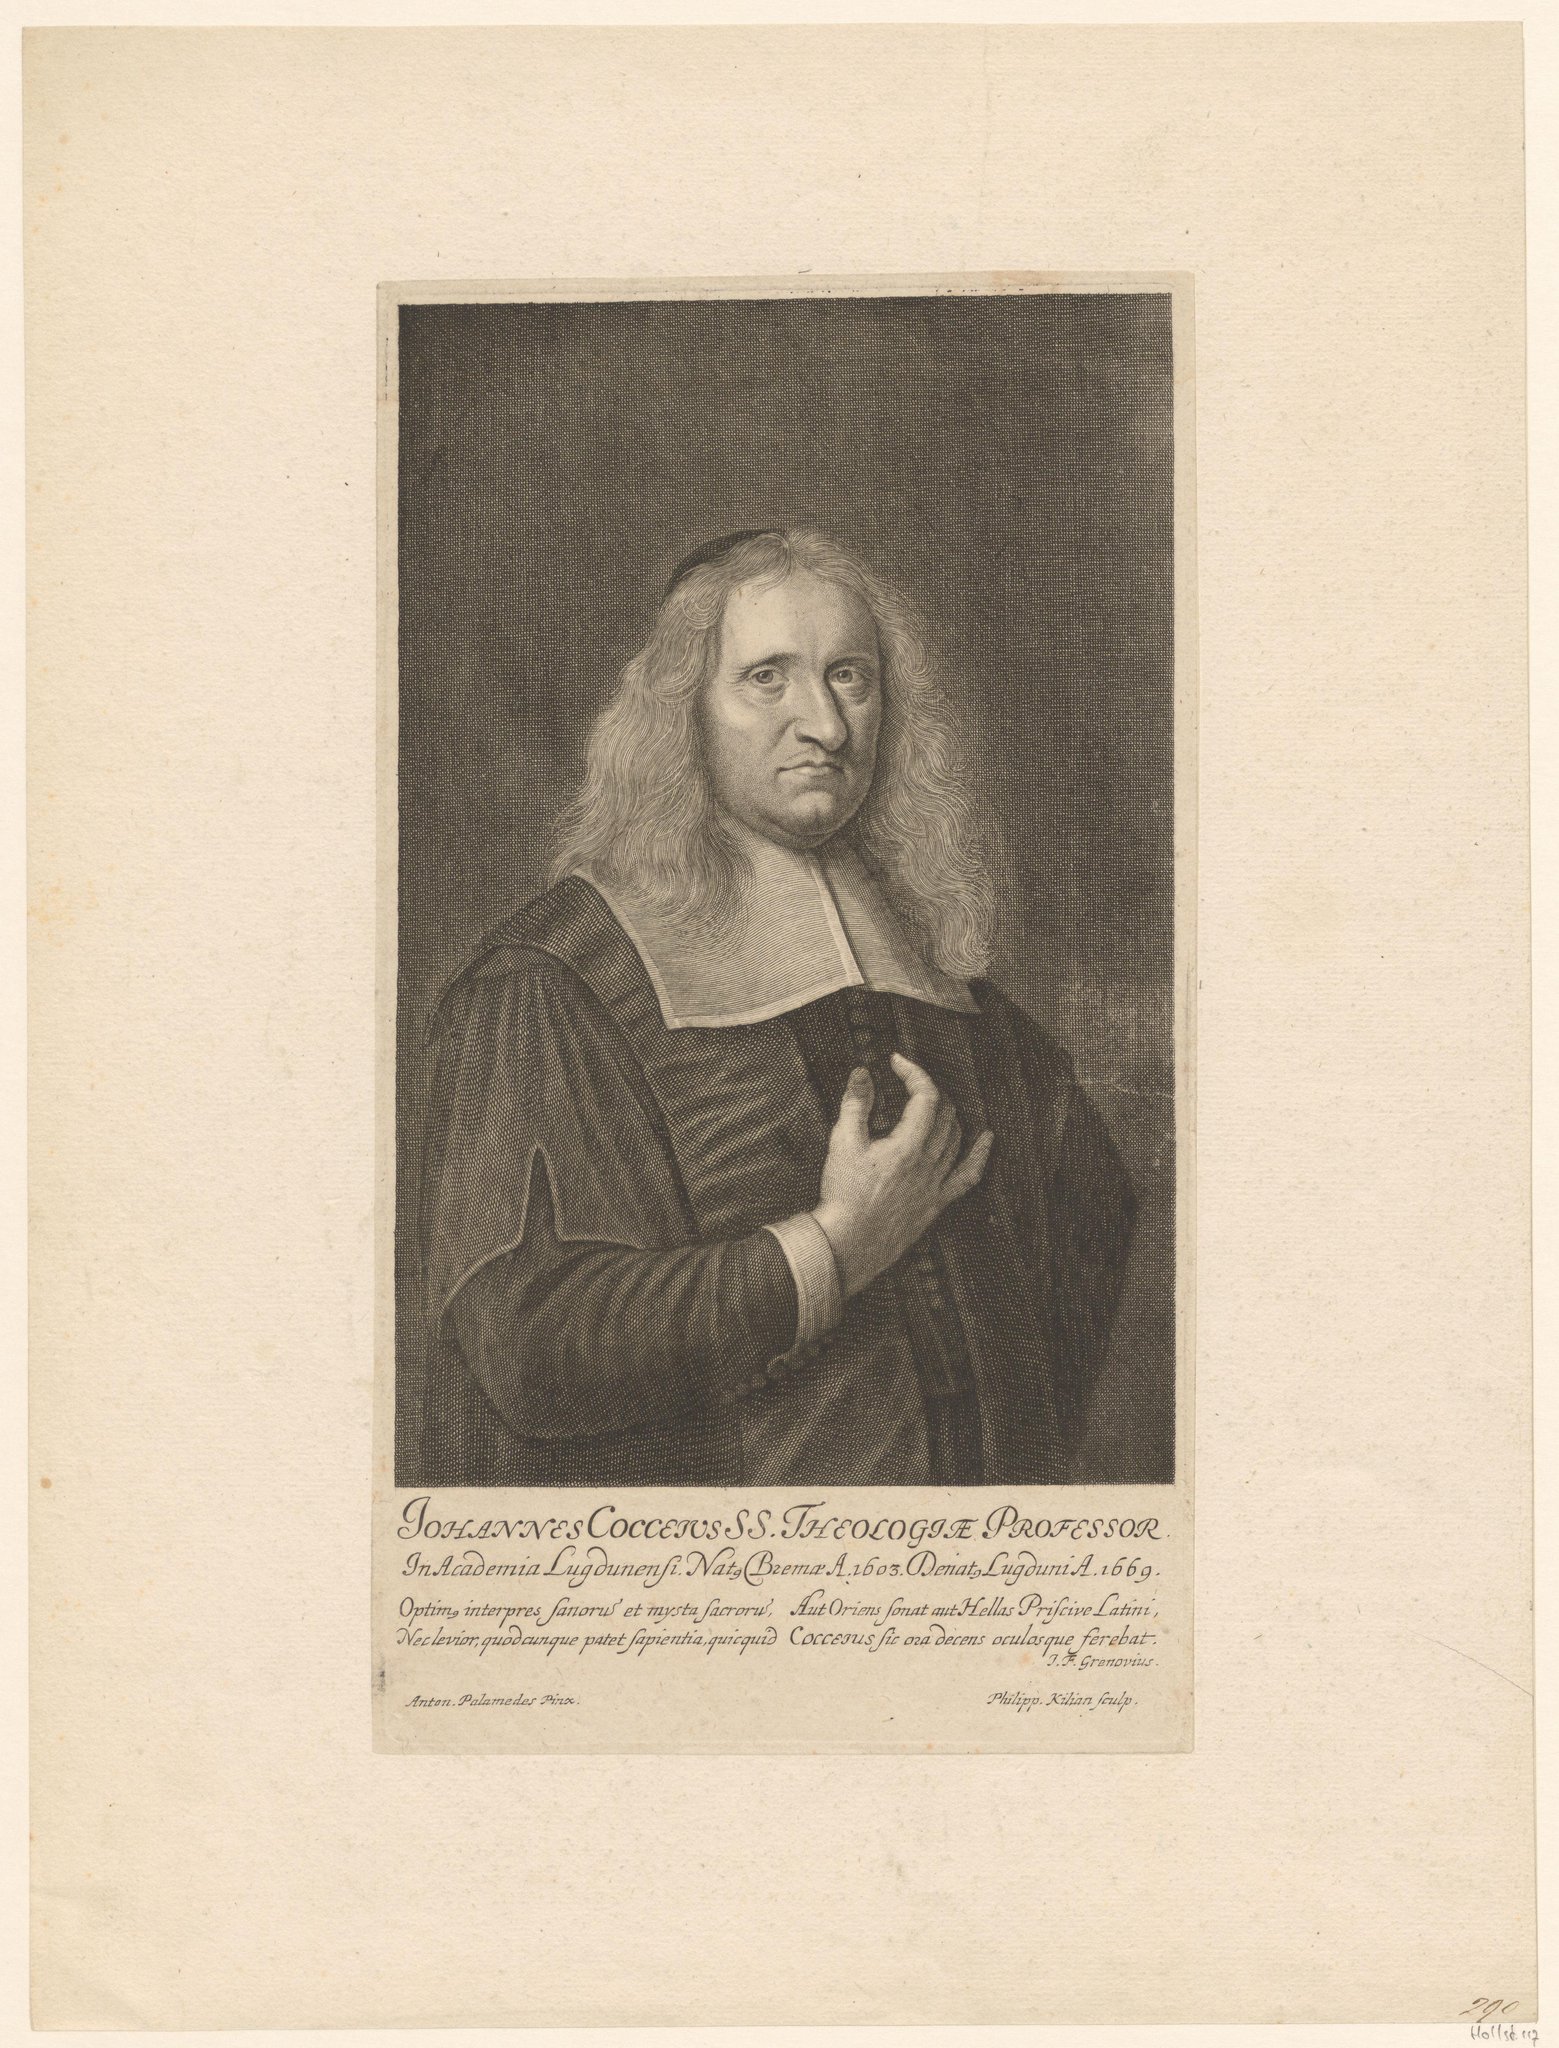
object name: print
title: Portret van Johannes Coccejus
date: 1669-1693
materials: paper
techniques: engraving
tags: leiden, theologian, historical persons